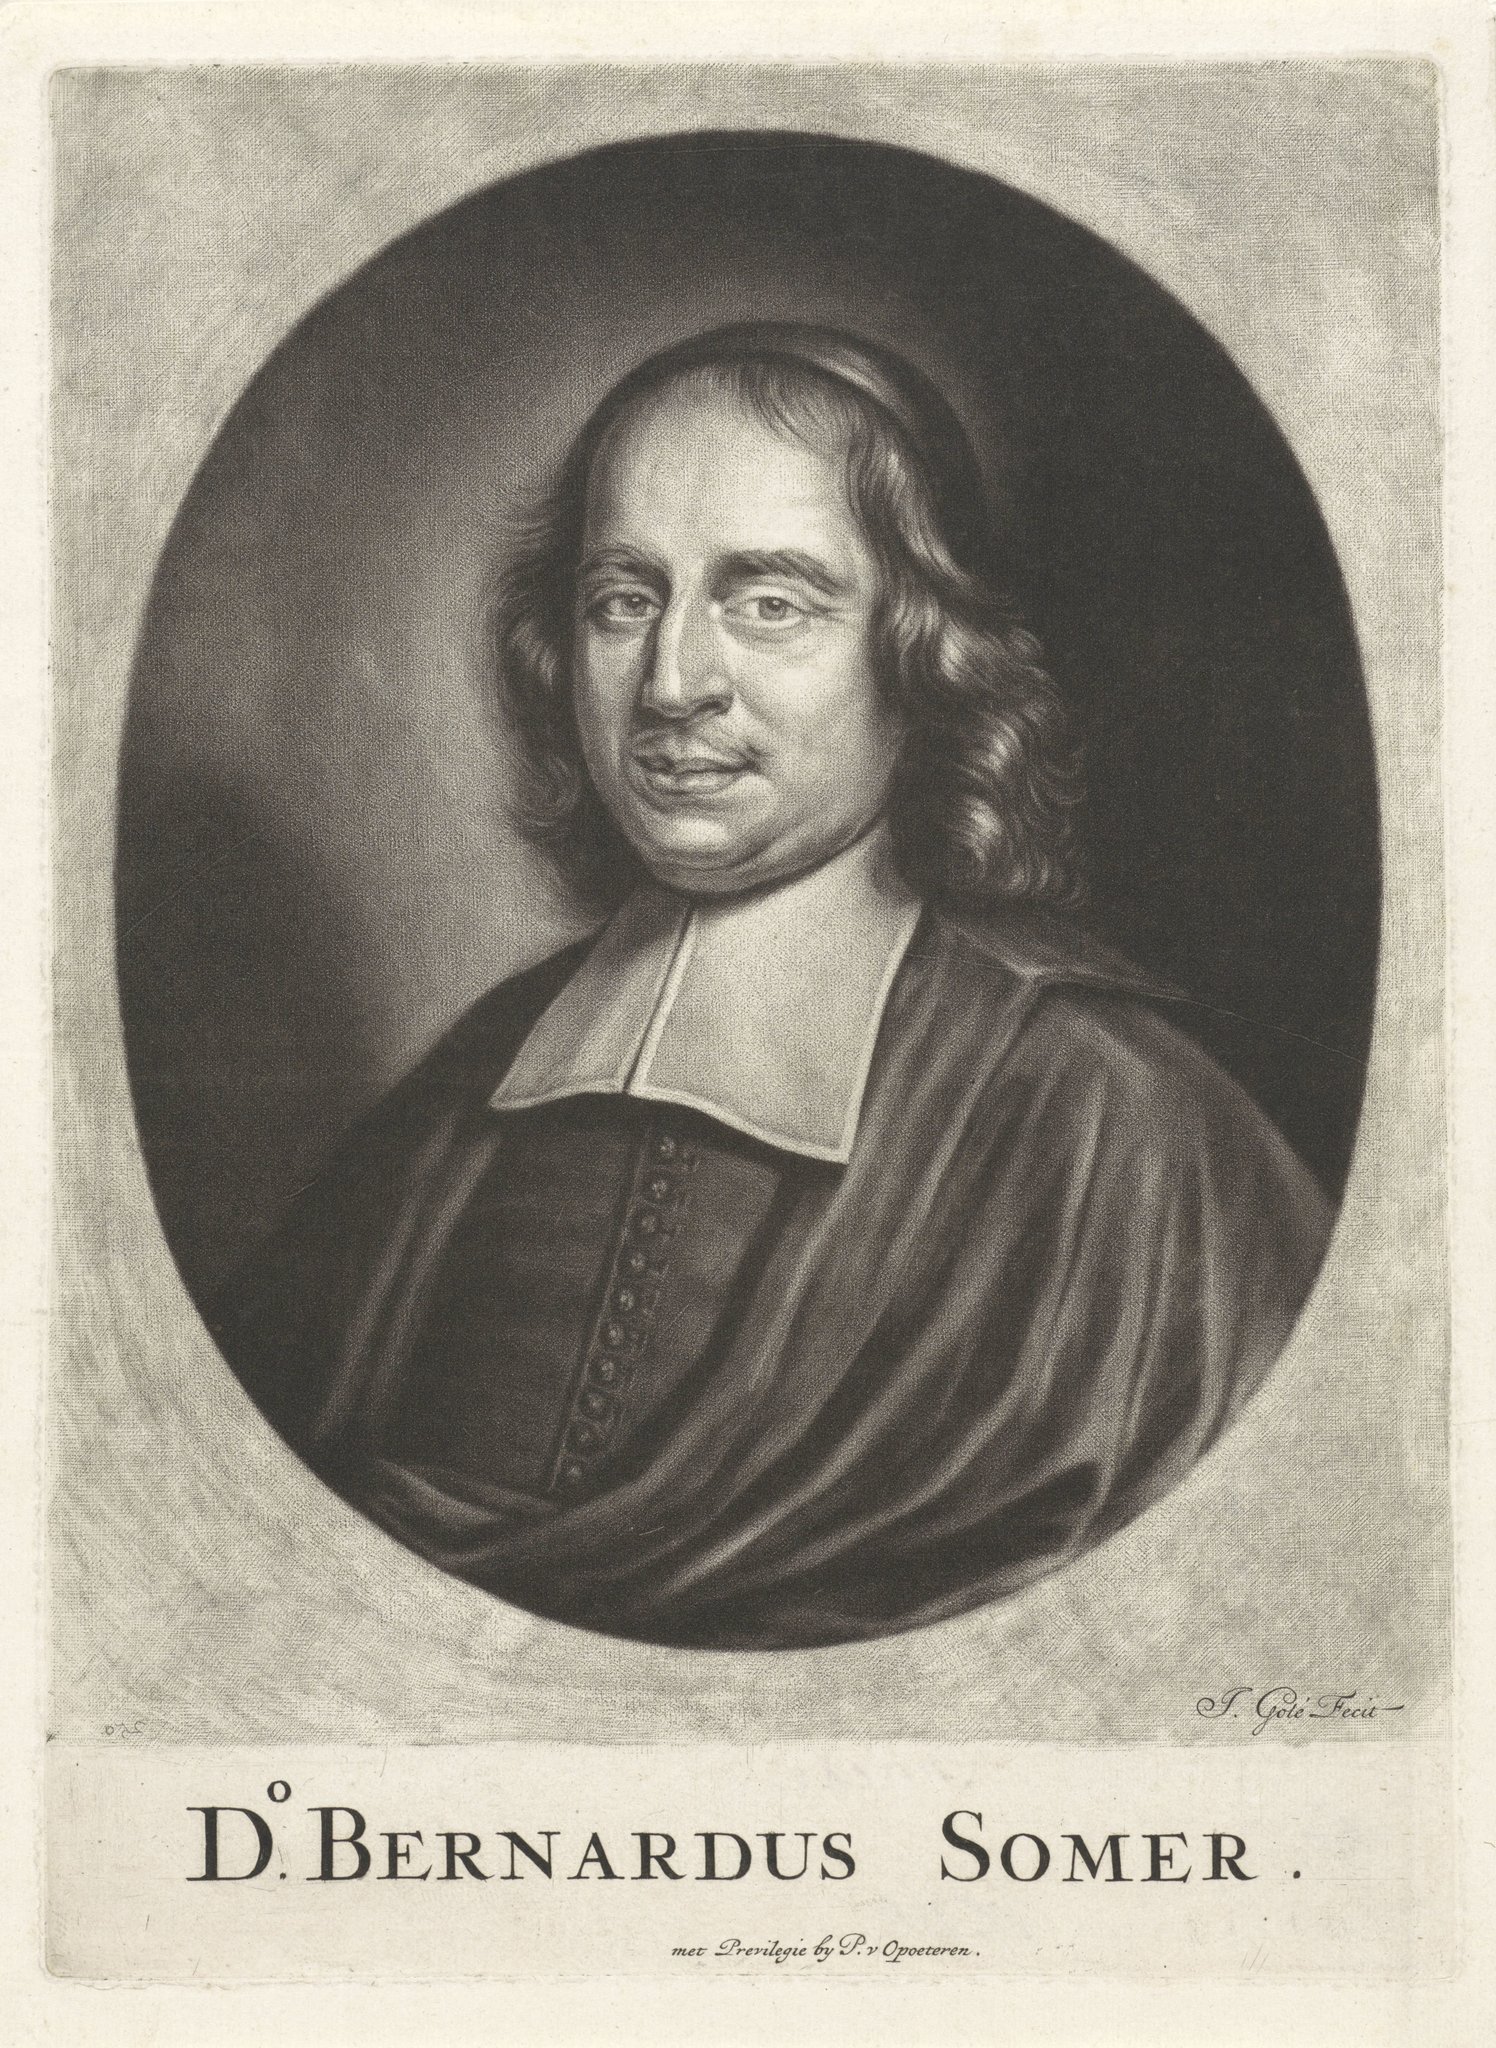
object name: print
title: Portret van Bernardus Somer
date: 1670-1724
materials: paper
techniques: engraving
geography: amsterdam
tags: flushing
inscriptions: collector's mark: Lugt 2228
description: Bernardus Somer, predikant te Amsterdam en in andere steden.